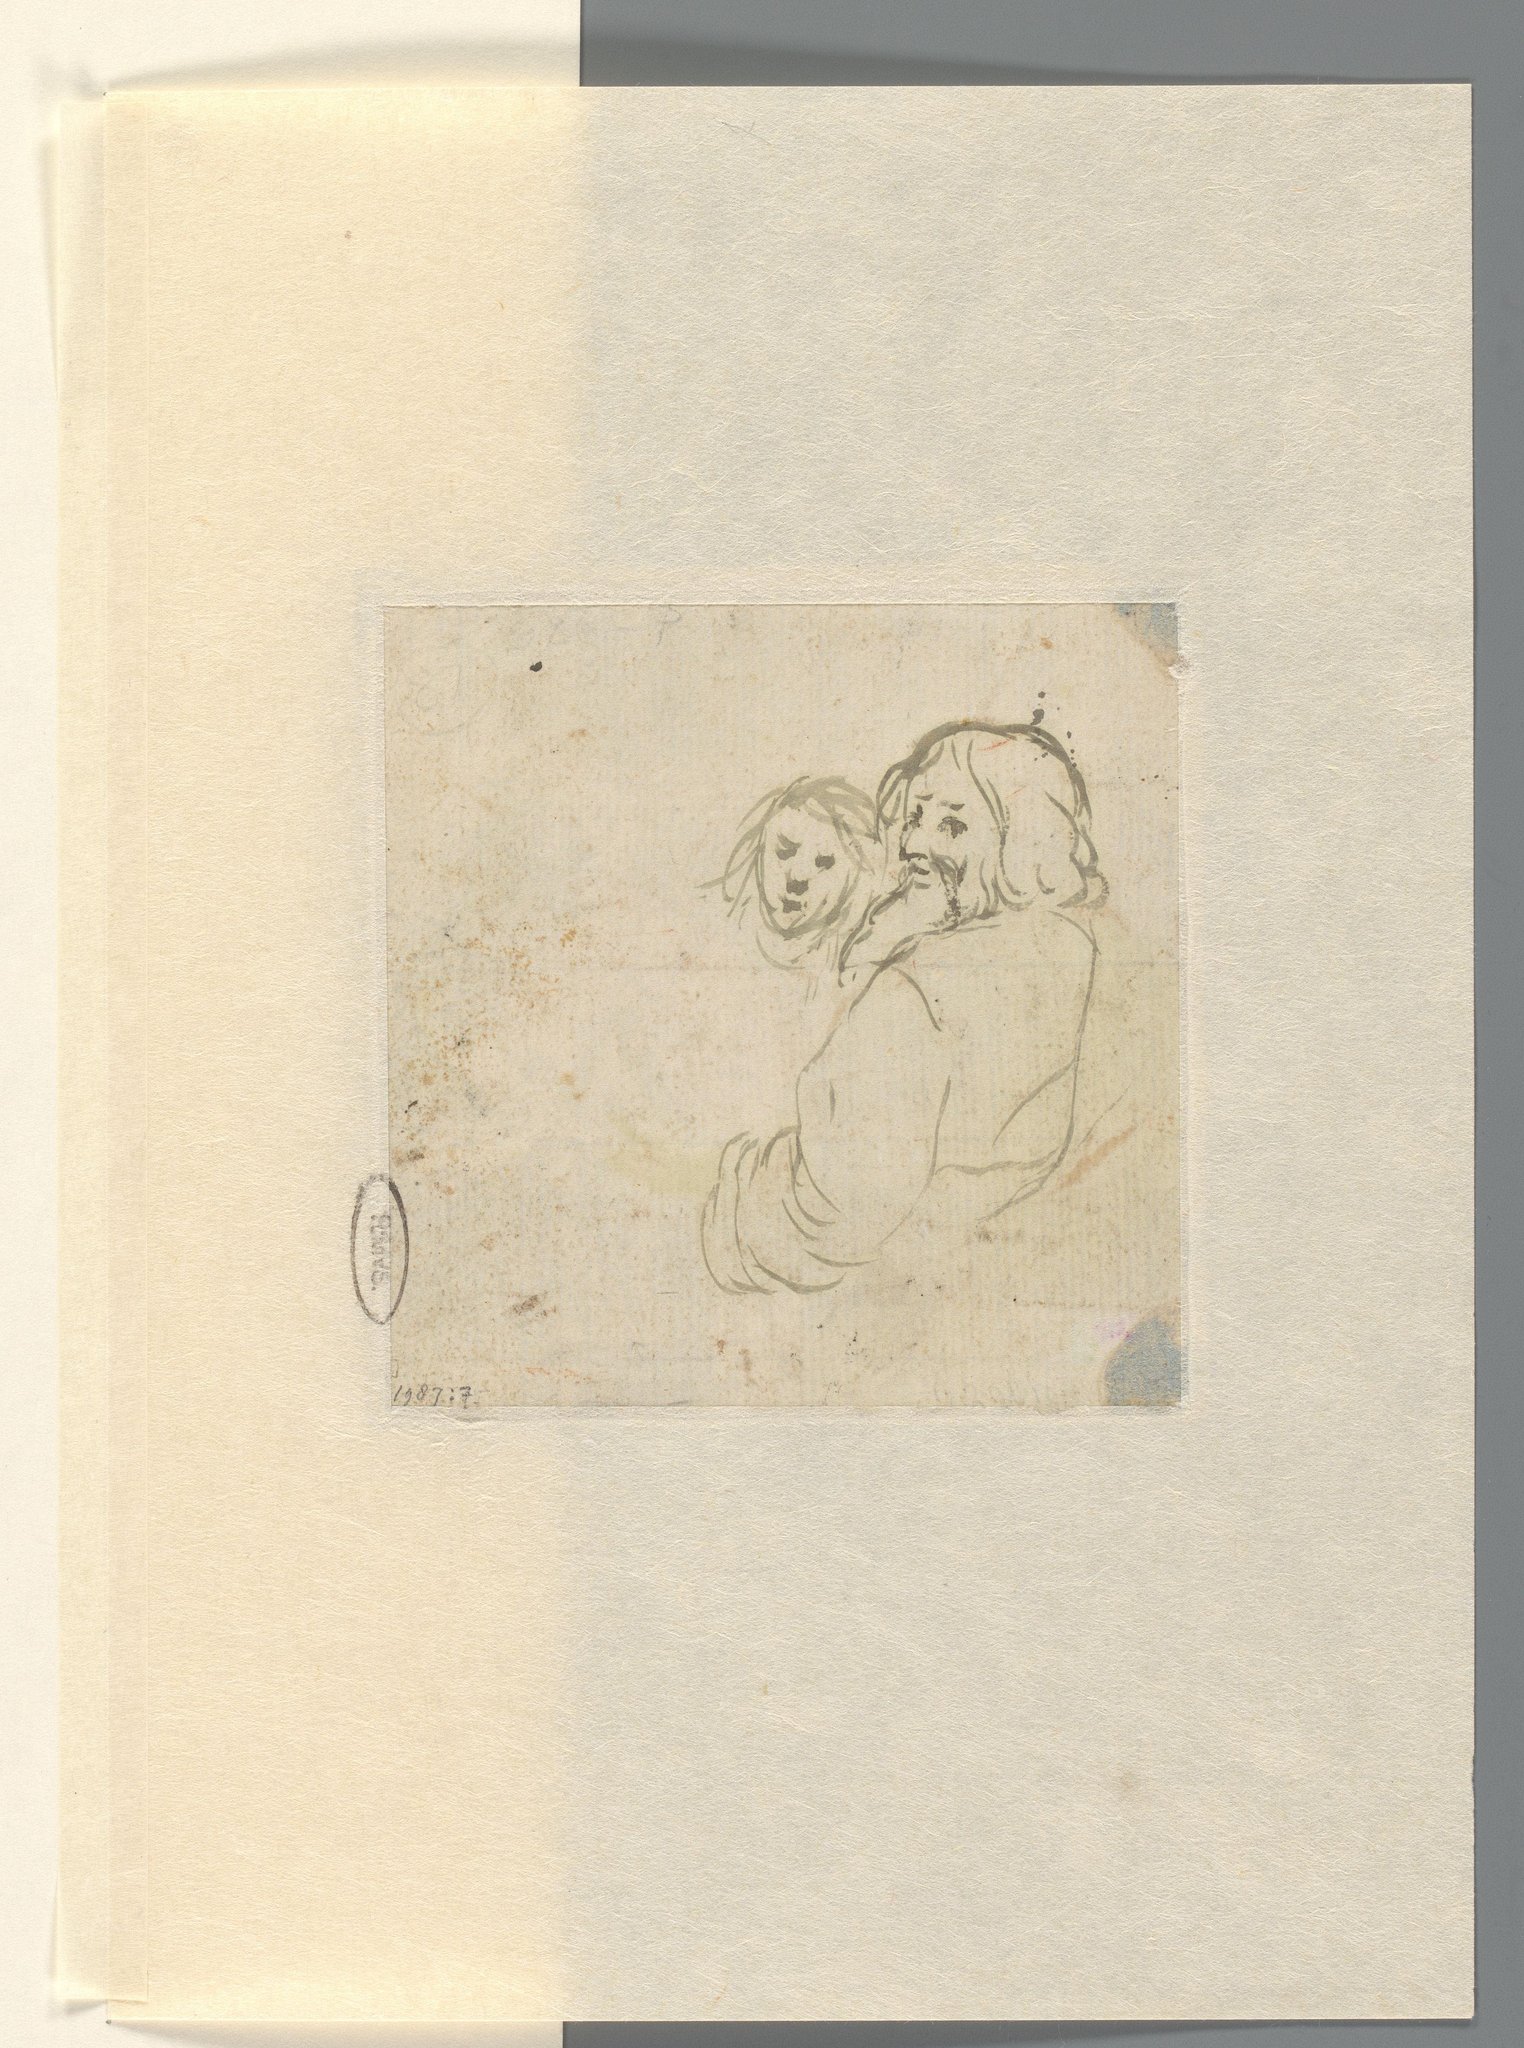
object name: drawing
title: Gebaarde man en een vrouwenhoofdje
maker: jacob duck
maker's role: draughtsman, painter, print maker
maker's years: 1600-1667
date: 1610-1660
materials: paper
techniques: brush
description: De gebaarde man van de voorzijde in een andere houding en een vrouwenhoofdje.